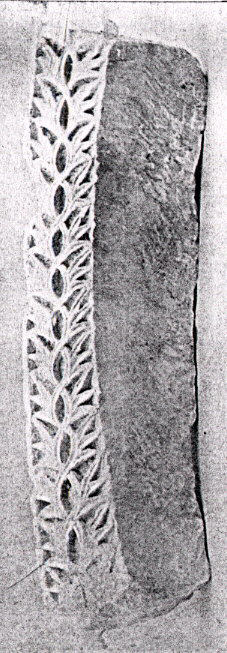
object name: fragment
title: Fragment of Archivolt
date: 501-700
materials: limestone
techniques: carving, relief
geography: egypt